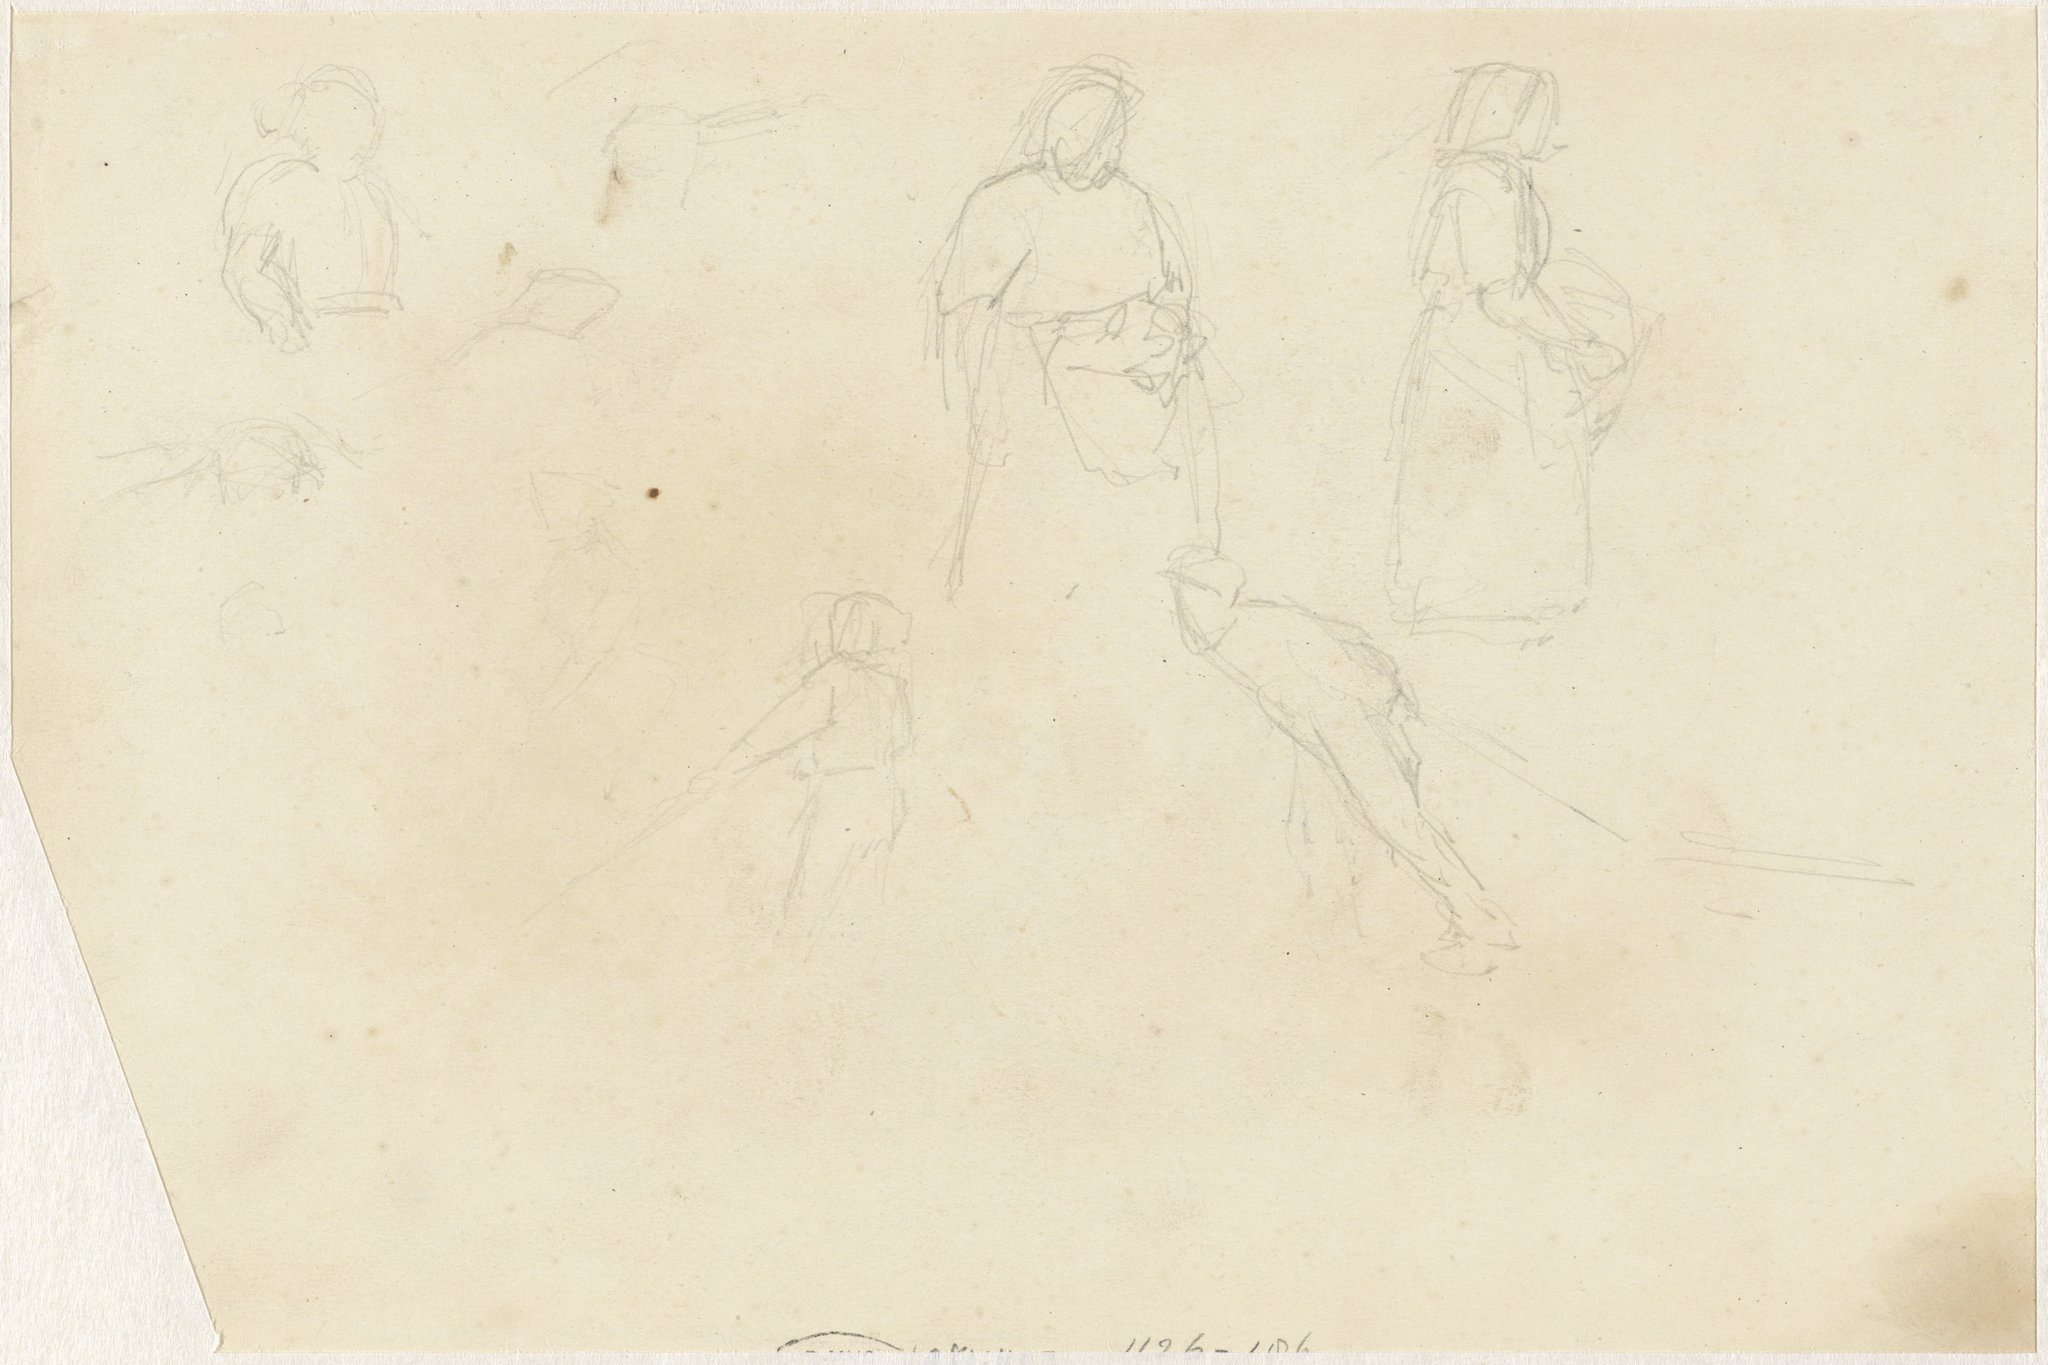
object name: drawing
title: Enkele figuurschetsen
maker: jozef israëls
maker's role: draughtsman, painter, print maker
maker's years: 1824-1911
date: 1834-1911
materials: paper, pencil